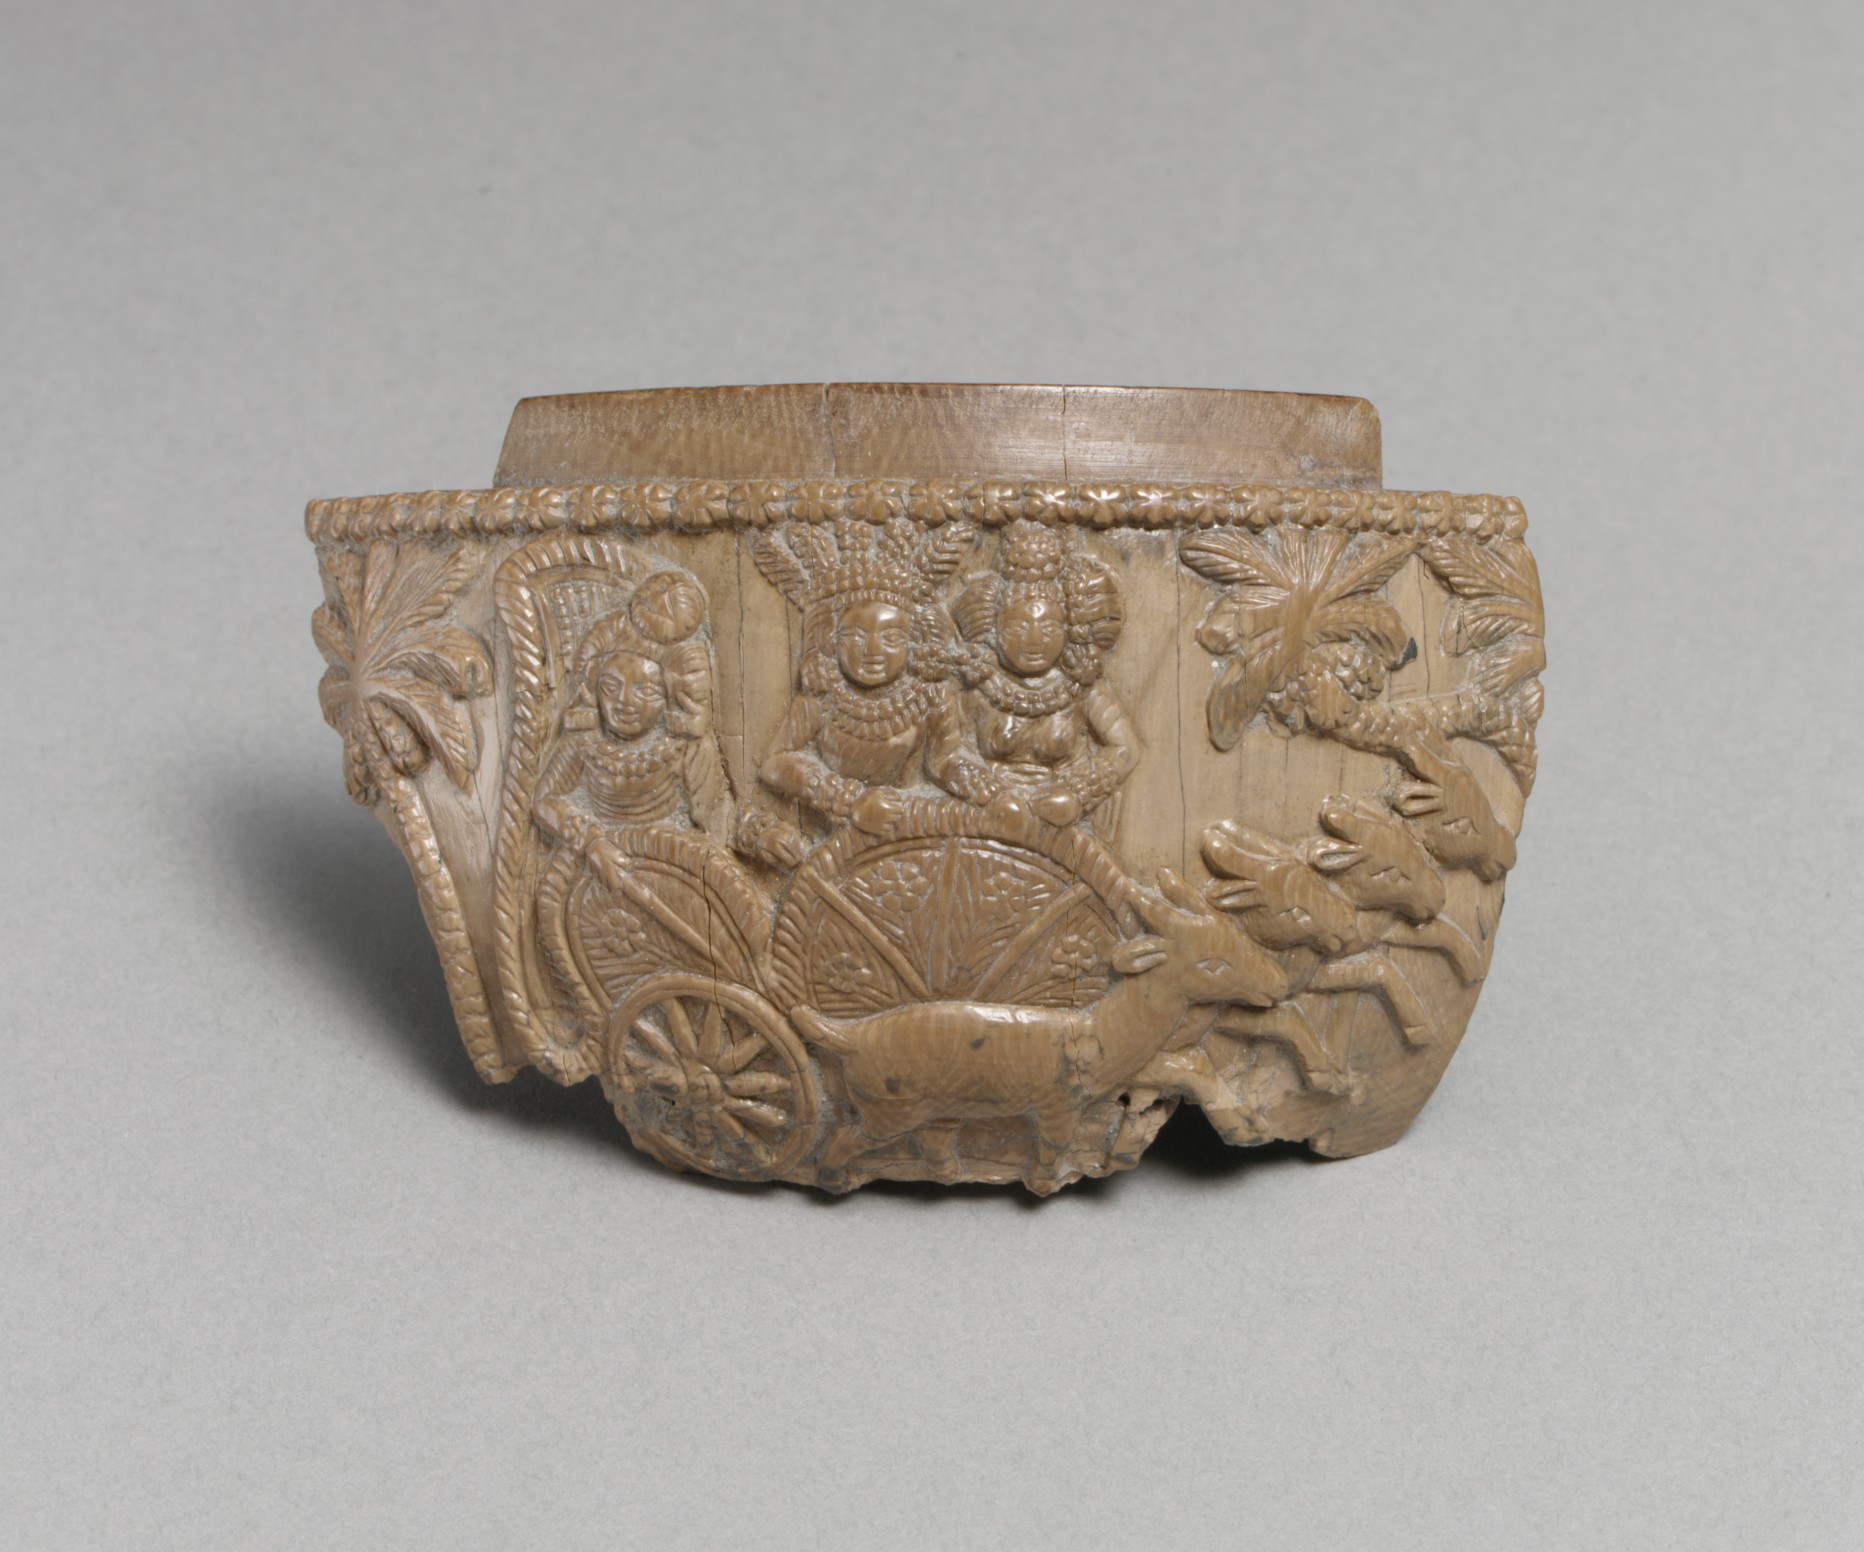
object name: fragment of a bowl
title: The Moon God Chandra(?) in His Chariot with Wife and Attendant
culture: indian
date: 200-1 BCE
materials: ivory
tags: men,women,goats,chariots